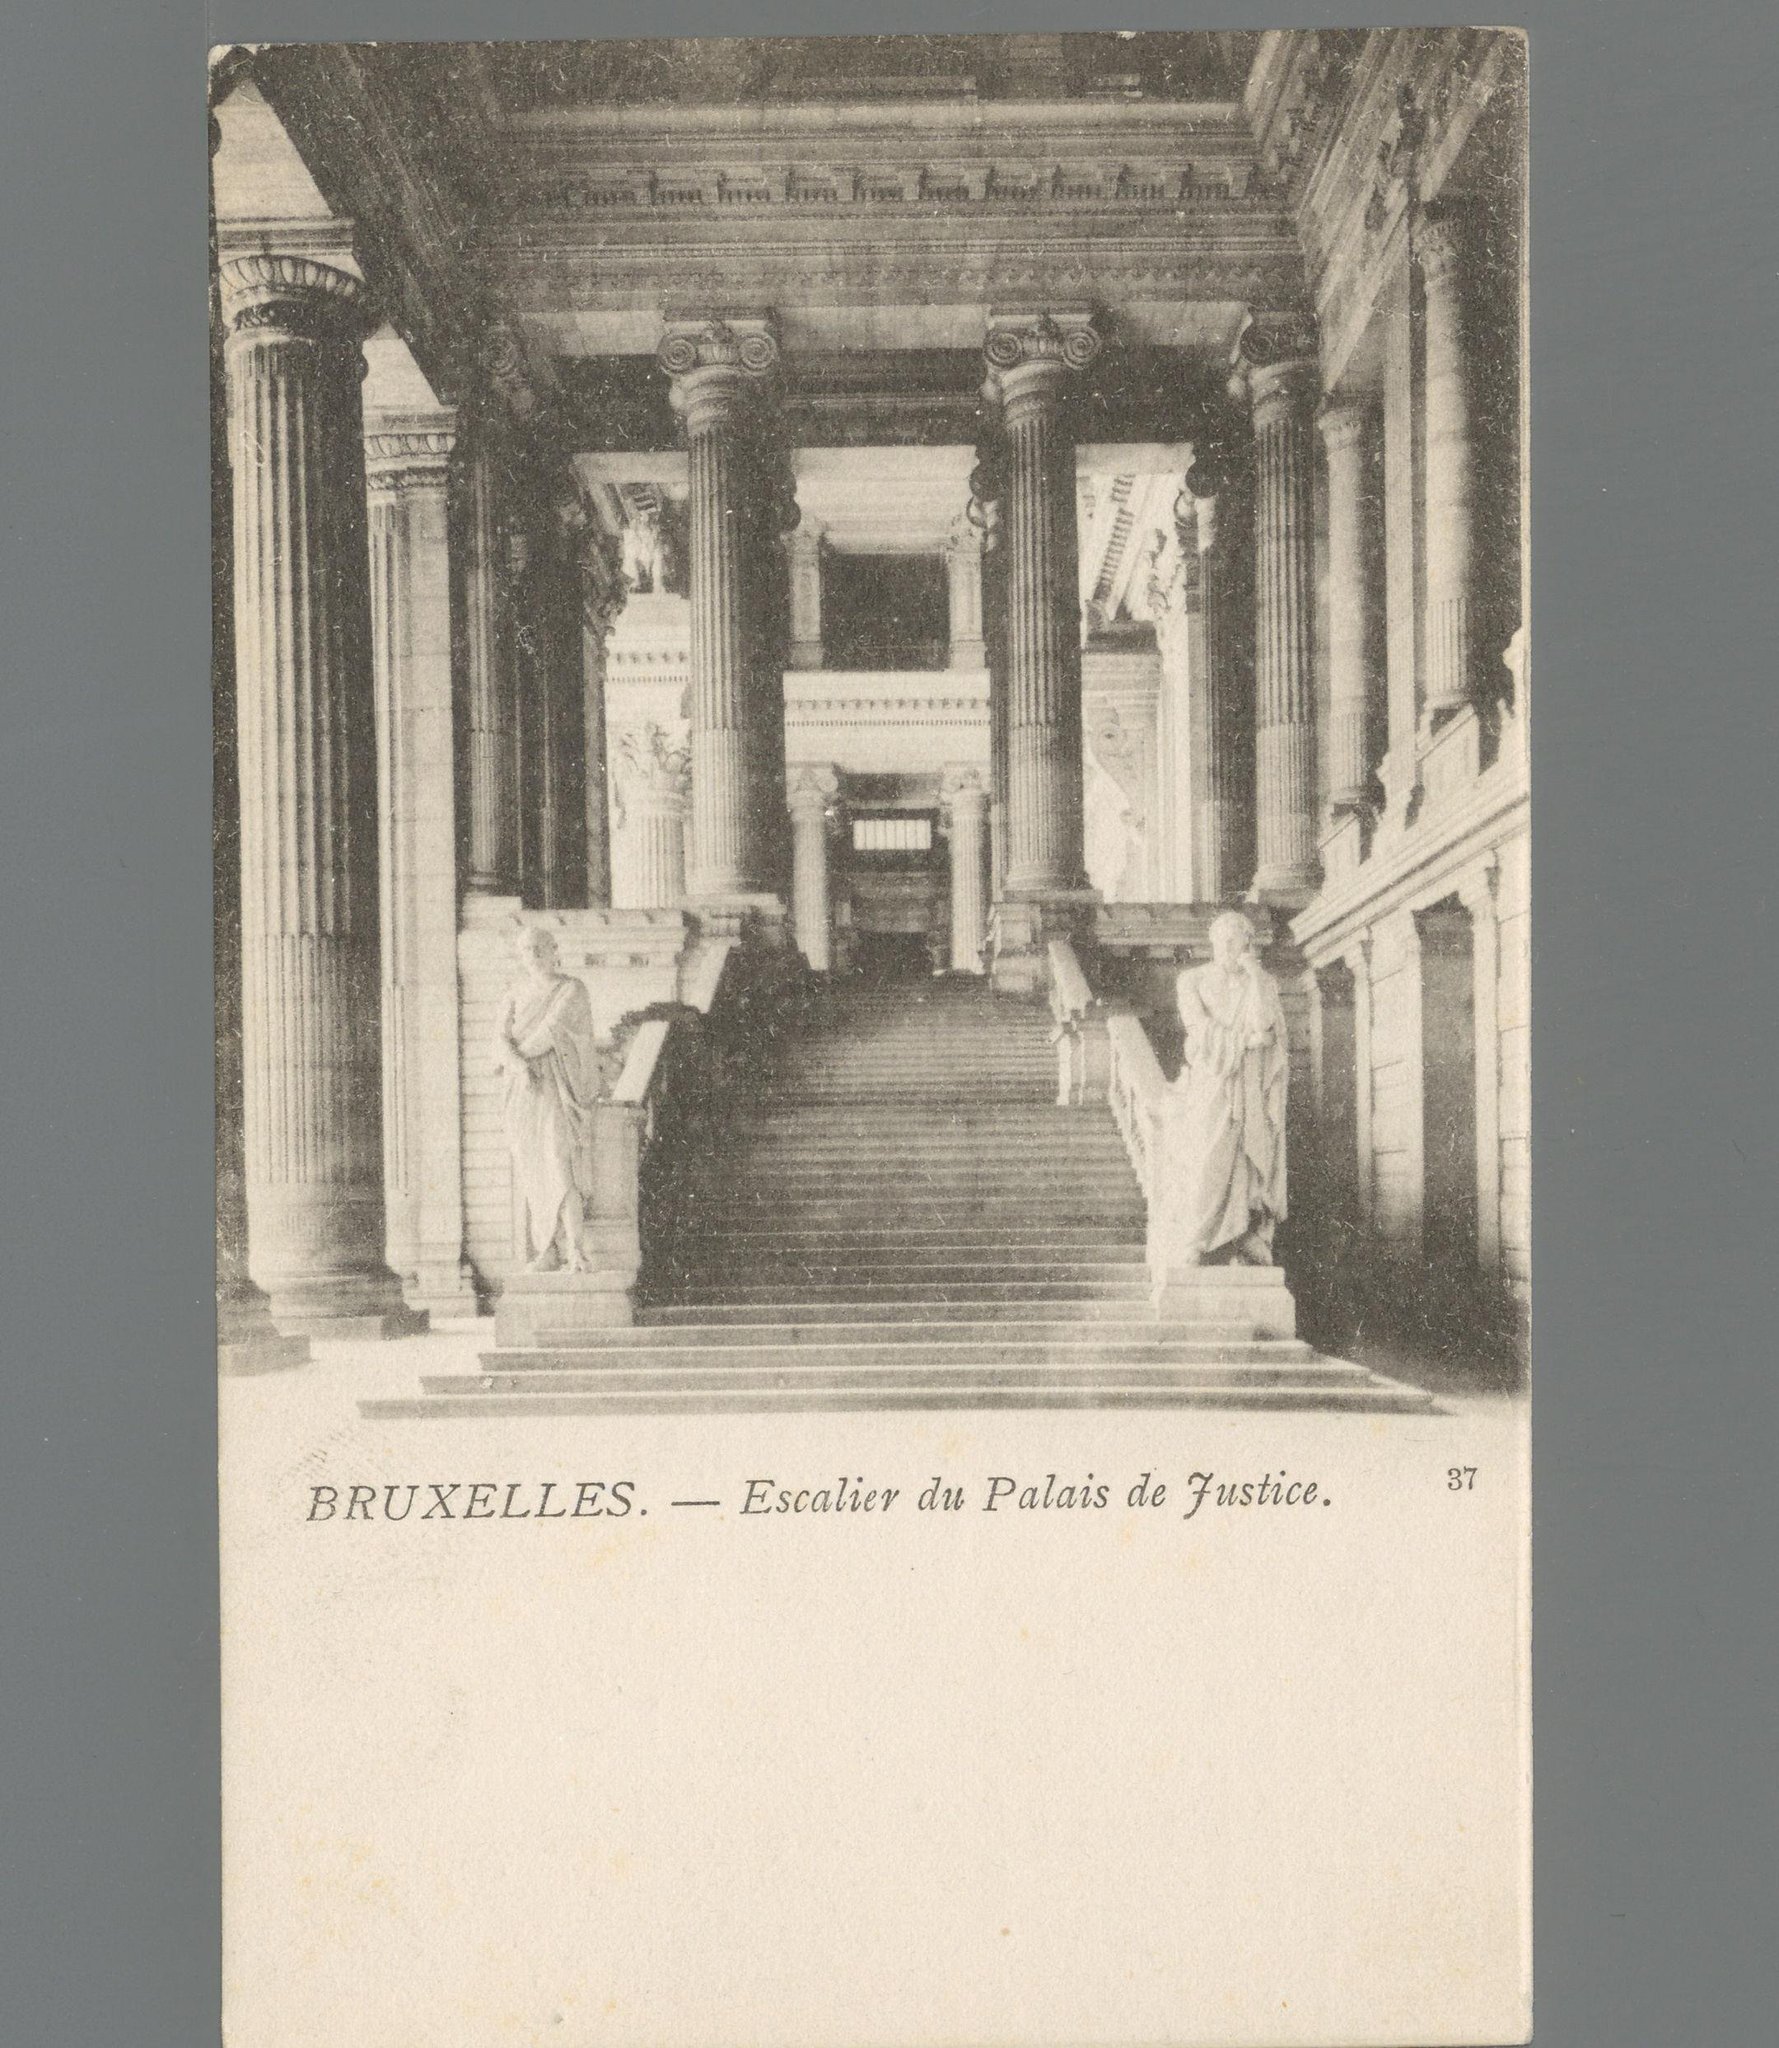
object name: ansichtkaart, prentbriefkaart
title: Bruxelles. Escalier du Palais de Justice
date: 1900-1906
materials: cardboard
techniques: photograph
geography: brussels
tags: court building, staircase, interior ~ representation of a building